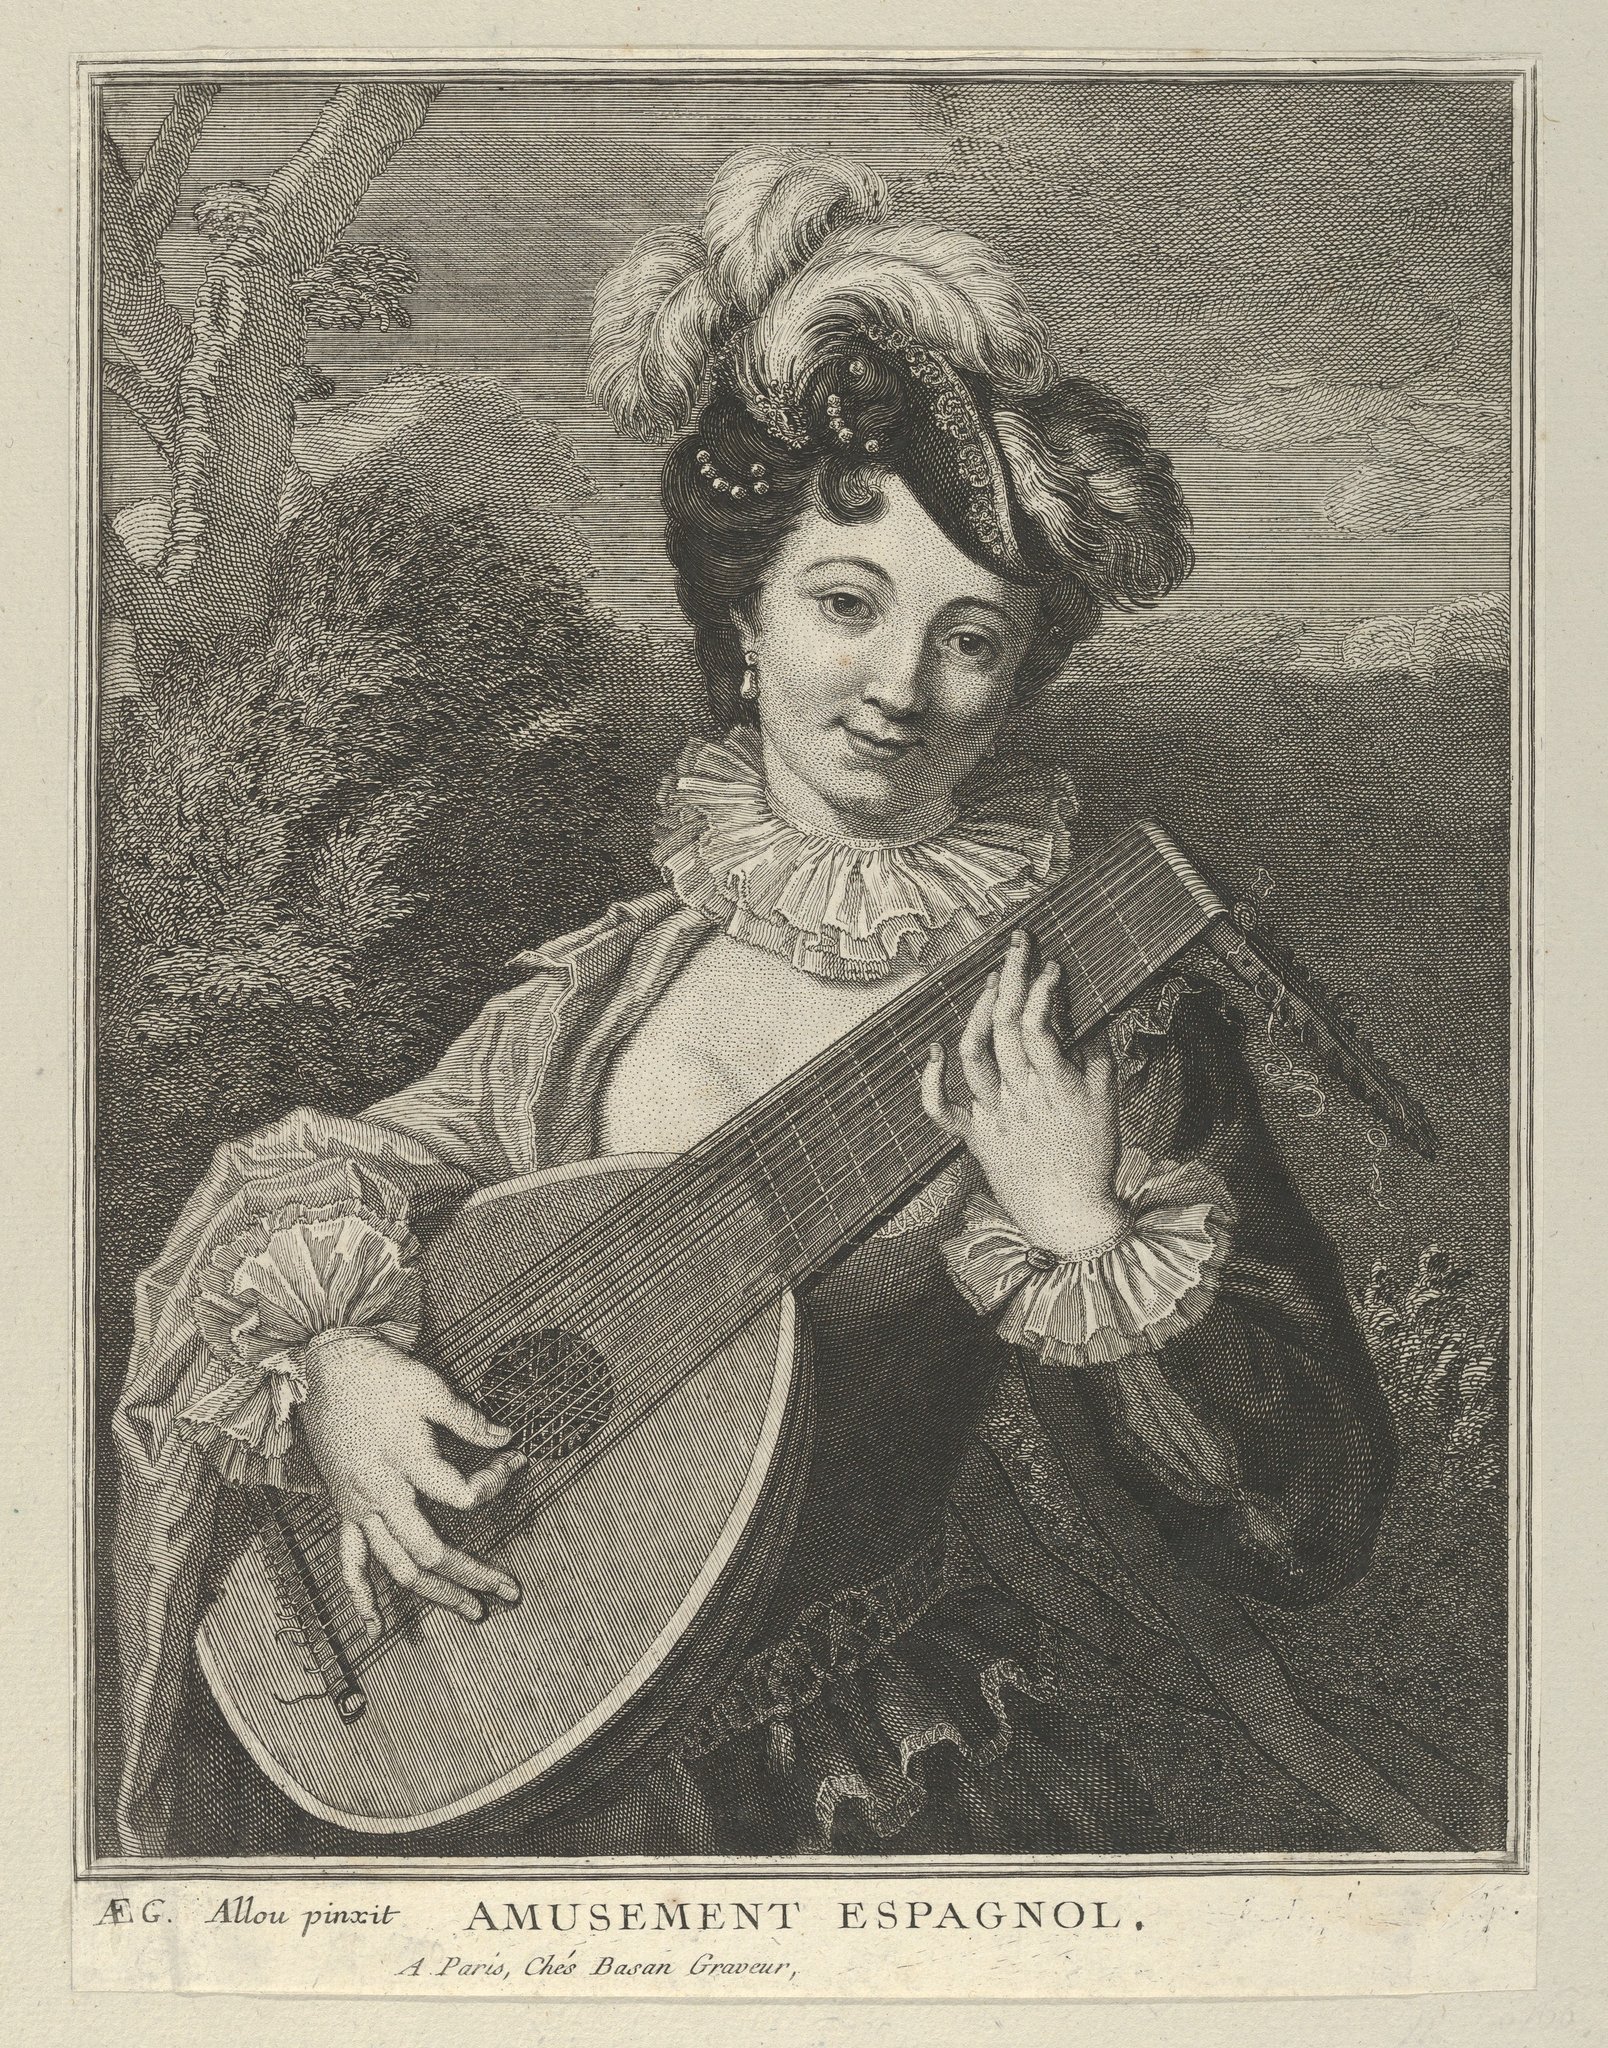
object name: print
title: Amusement Espagnol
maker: pierre françois basan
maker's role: artist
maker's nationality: french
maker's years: 1723-1797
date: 1701-1800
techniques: engraving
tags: portraits,women,lutes